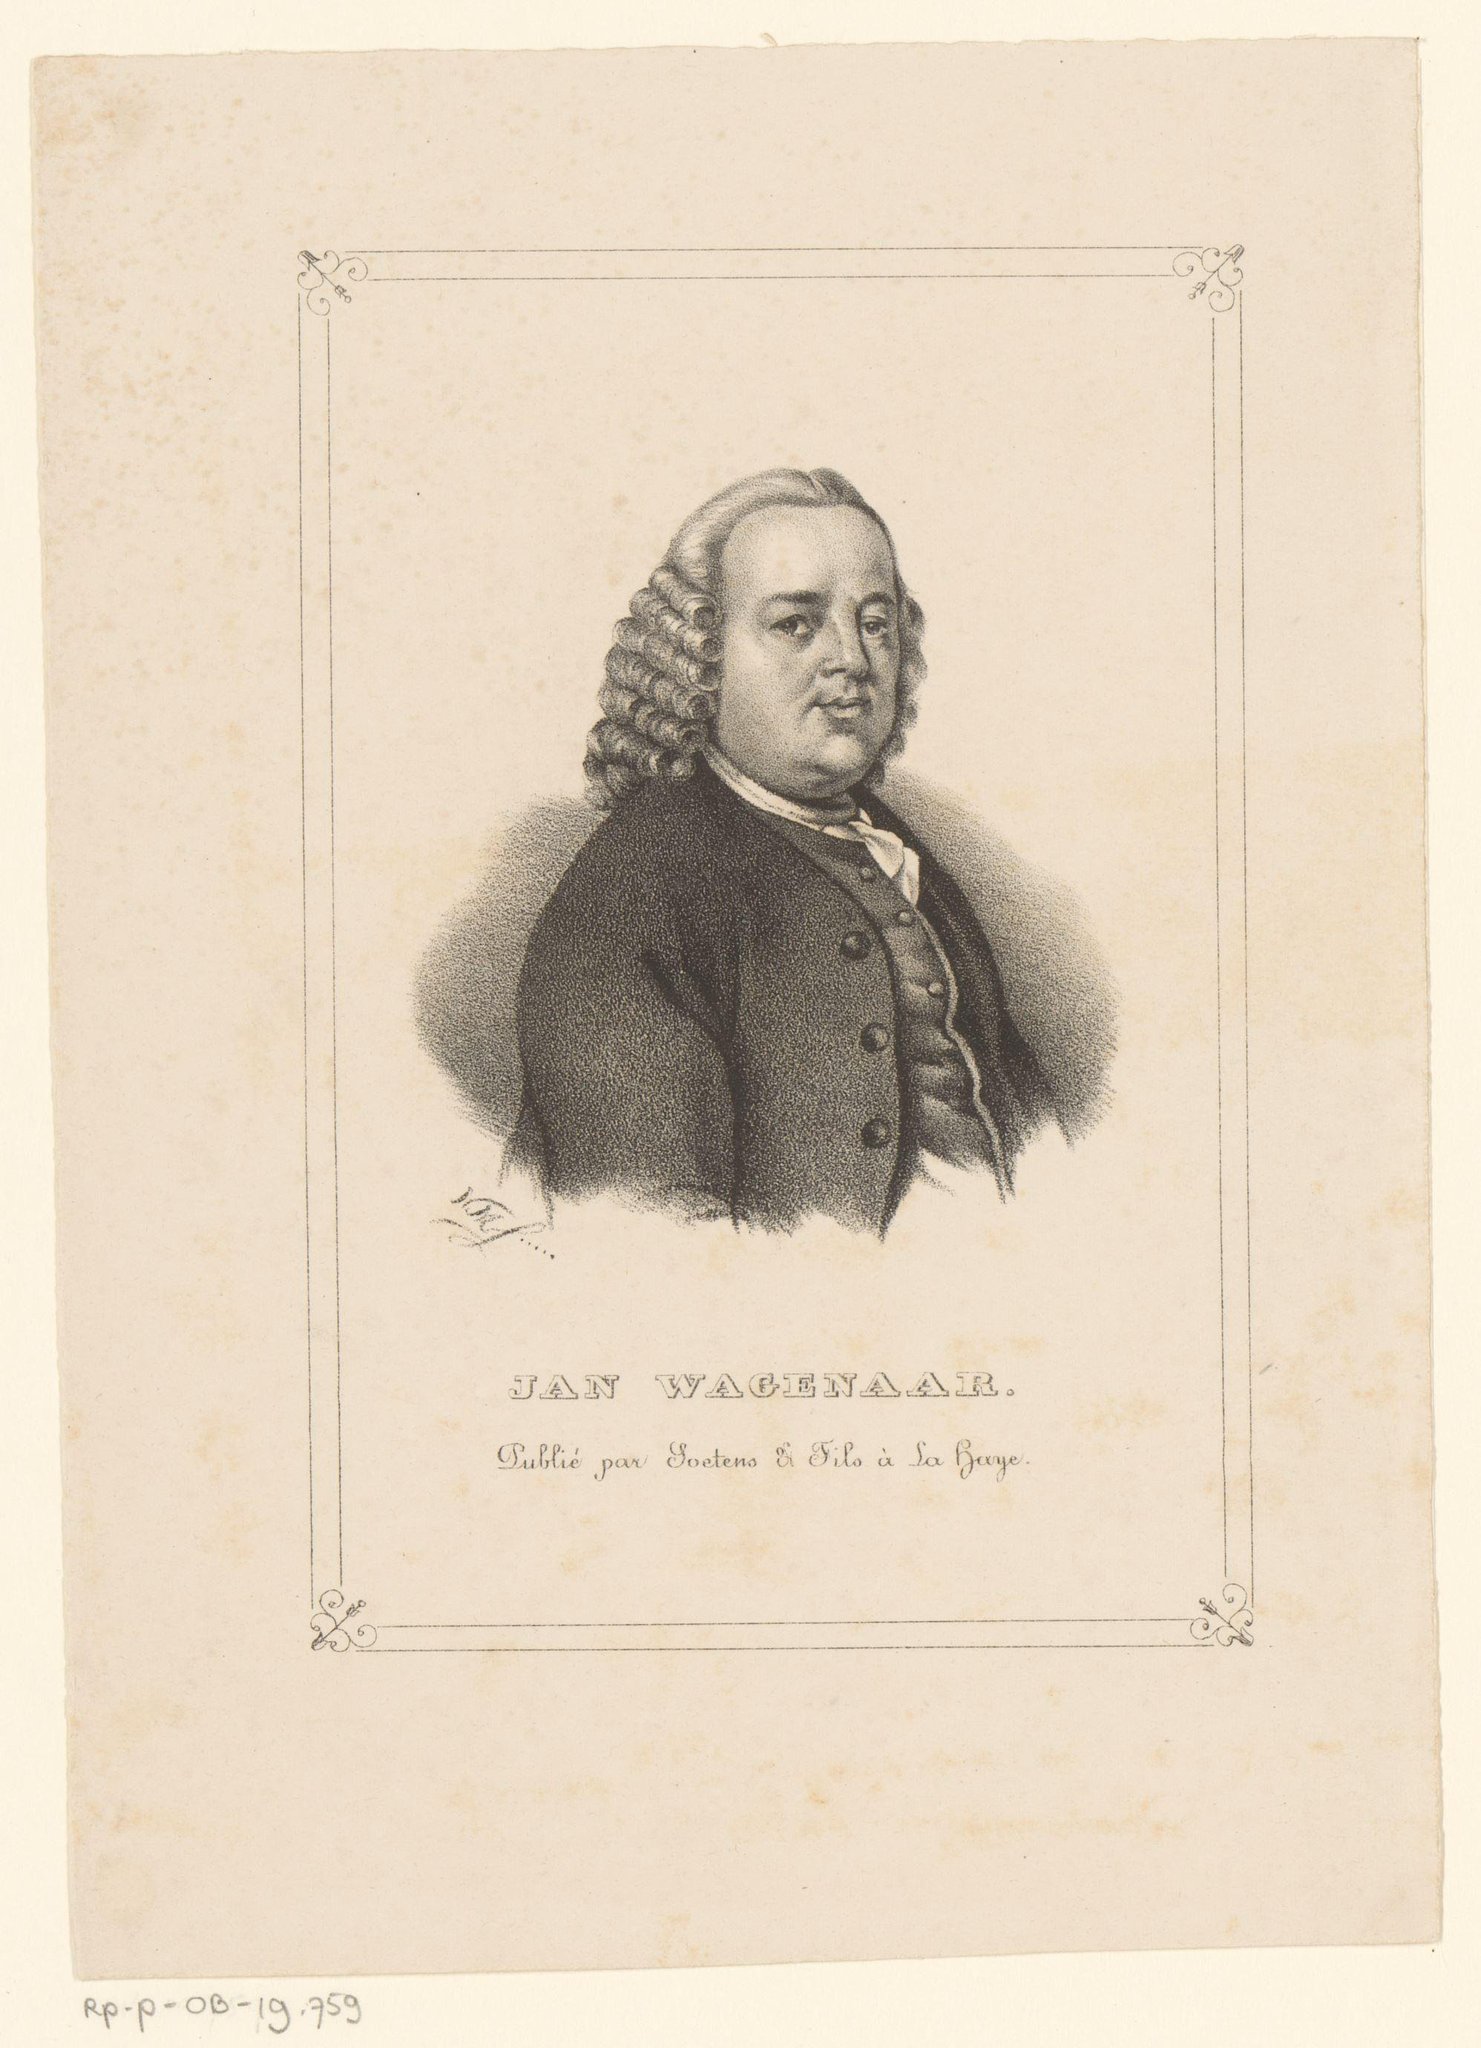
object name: print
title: Portret van Jan Wagenaar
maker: nicolaas martinus schild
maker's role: draughtsman, print maker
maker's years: 1822-1840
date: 1837-1840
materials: paper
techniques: lithograph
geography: the hague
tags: amsterdam, jan wagenaar, historical persons (+ (full) bust portrait)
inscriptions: collector's mark: Lugt 2228